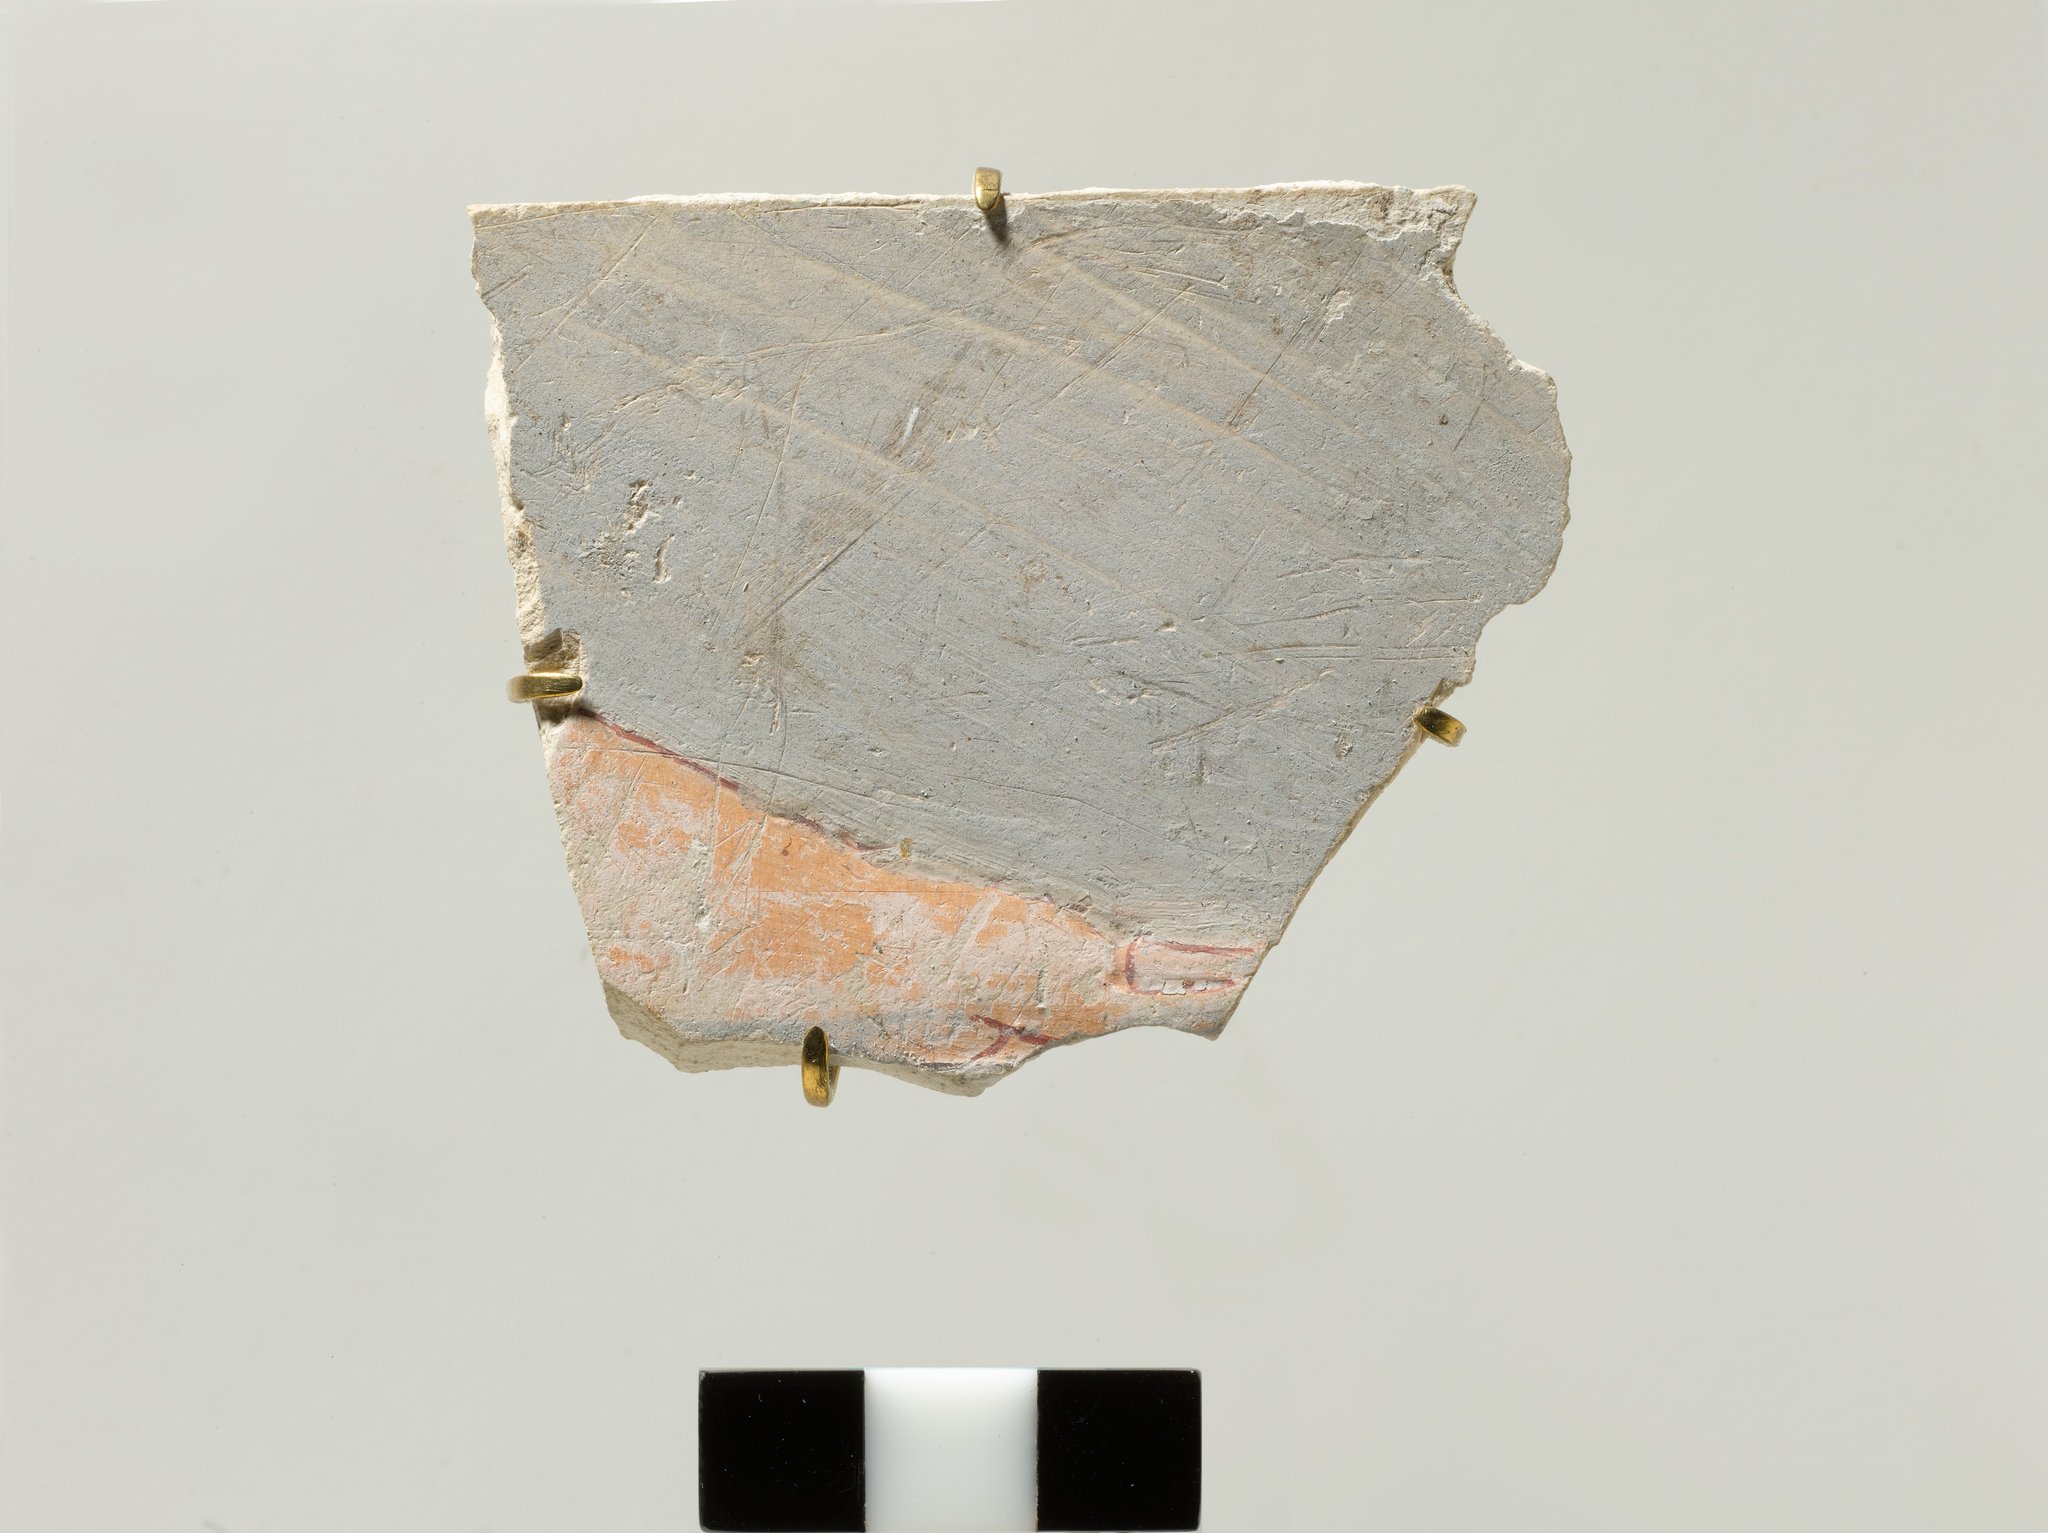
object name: relief fragment, tomb of meketre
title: Reliefs from the tomb of Meketre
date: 1981-1975 BCE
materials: limestone, paint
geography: egypt